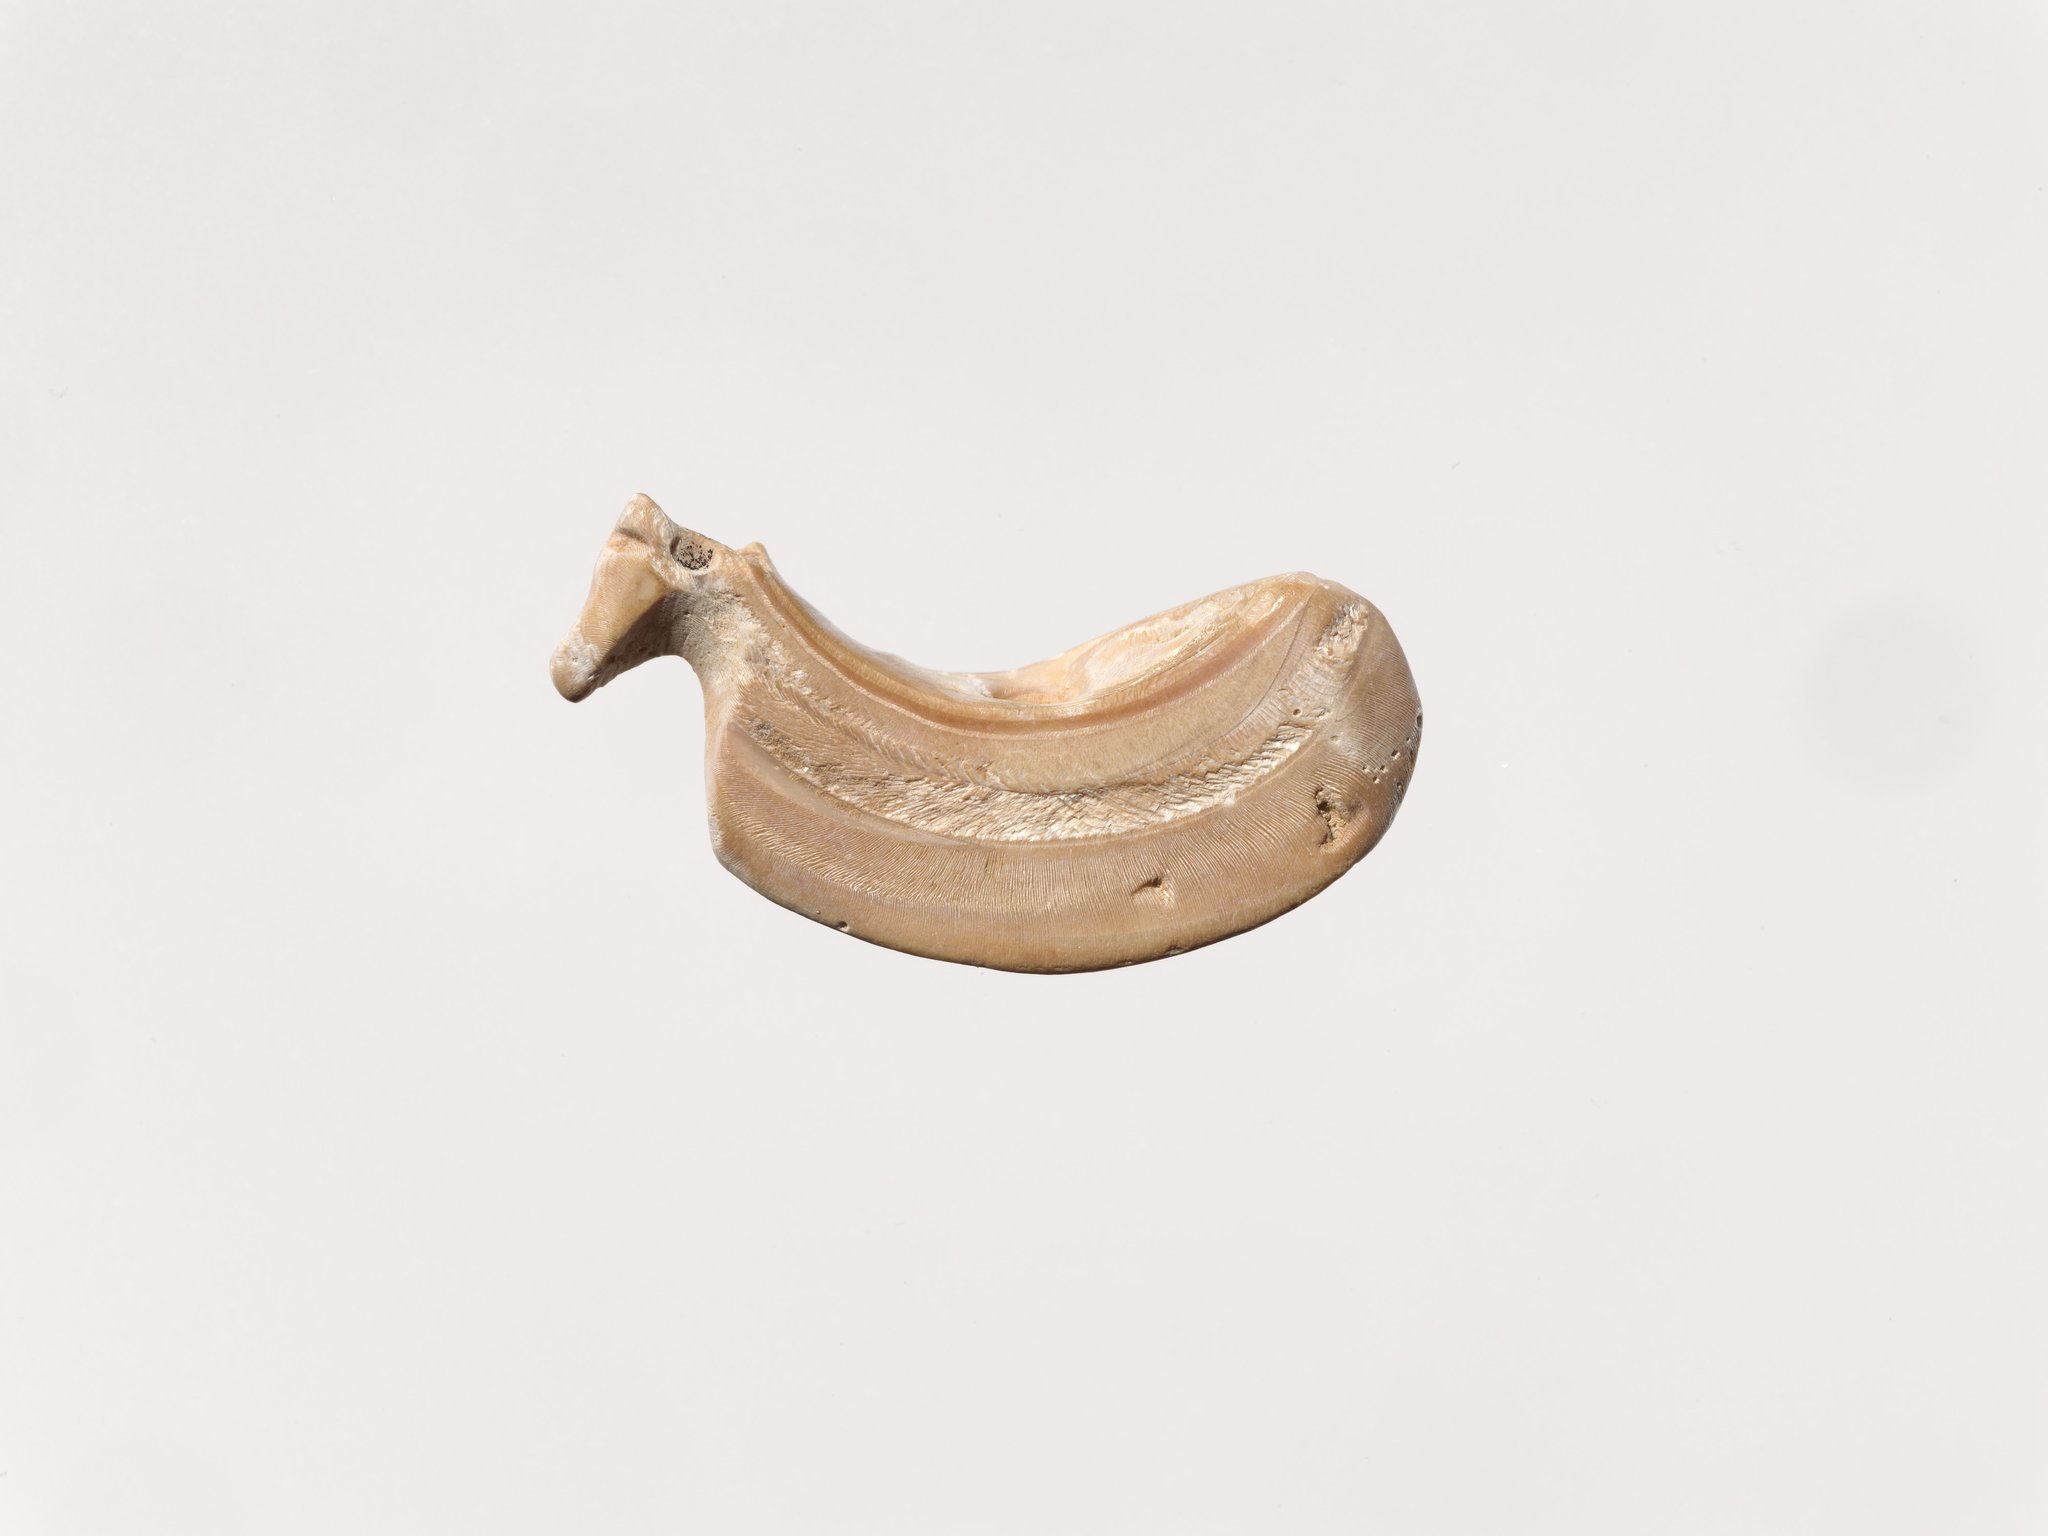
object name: necklace, bead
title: Cow amulet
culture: sumerian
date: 2700-2600 BCE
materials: shell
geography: mesopotamia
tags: cows